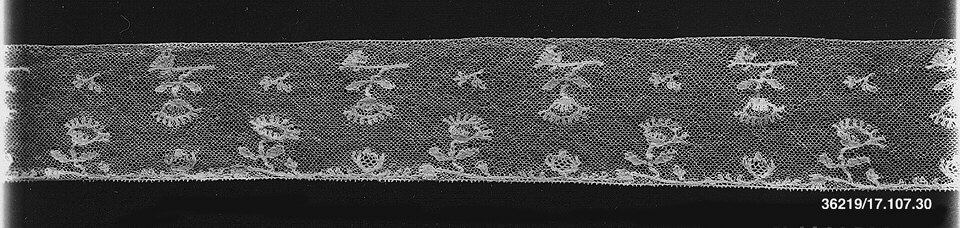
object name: piece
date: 1701-1900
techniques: lace